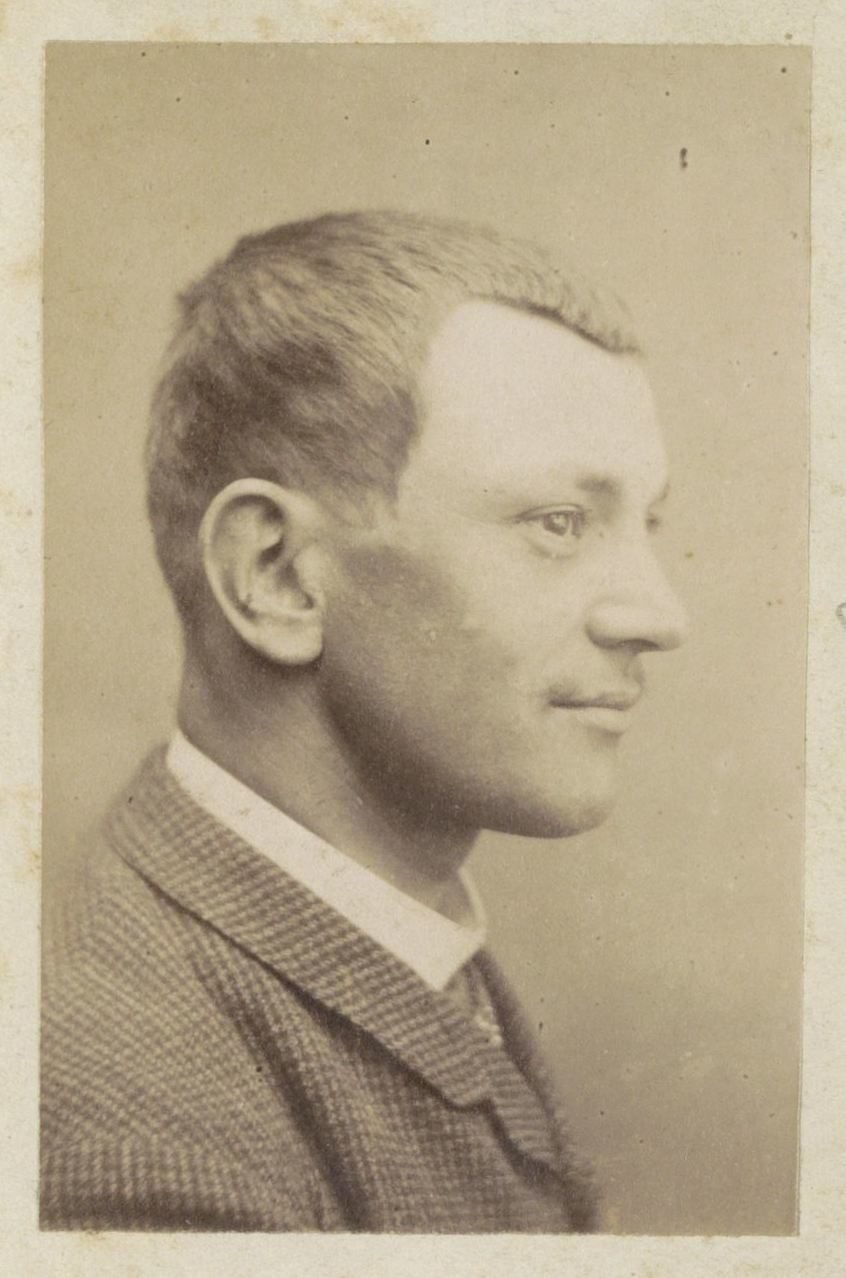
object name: photograph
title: Portret van een Fransman, aangeduid als Emile, en profil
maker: Anonymous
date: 1883-1886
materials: photographic support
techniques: albumen print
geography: france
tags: adult man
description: Onderdeel van Album van een Franse amateurfotograaf met opnames van familie, militairen, industrie, landschappen en bezienswaardigheden in Frankrijk.